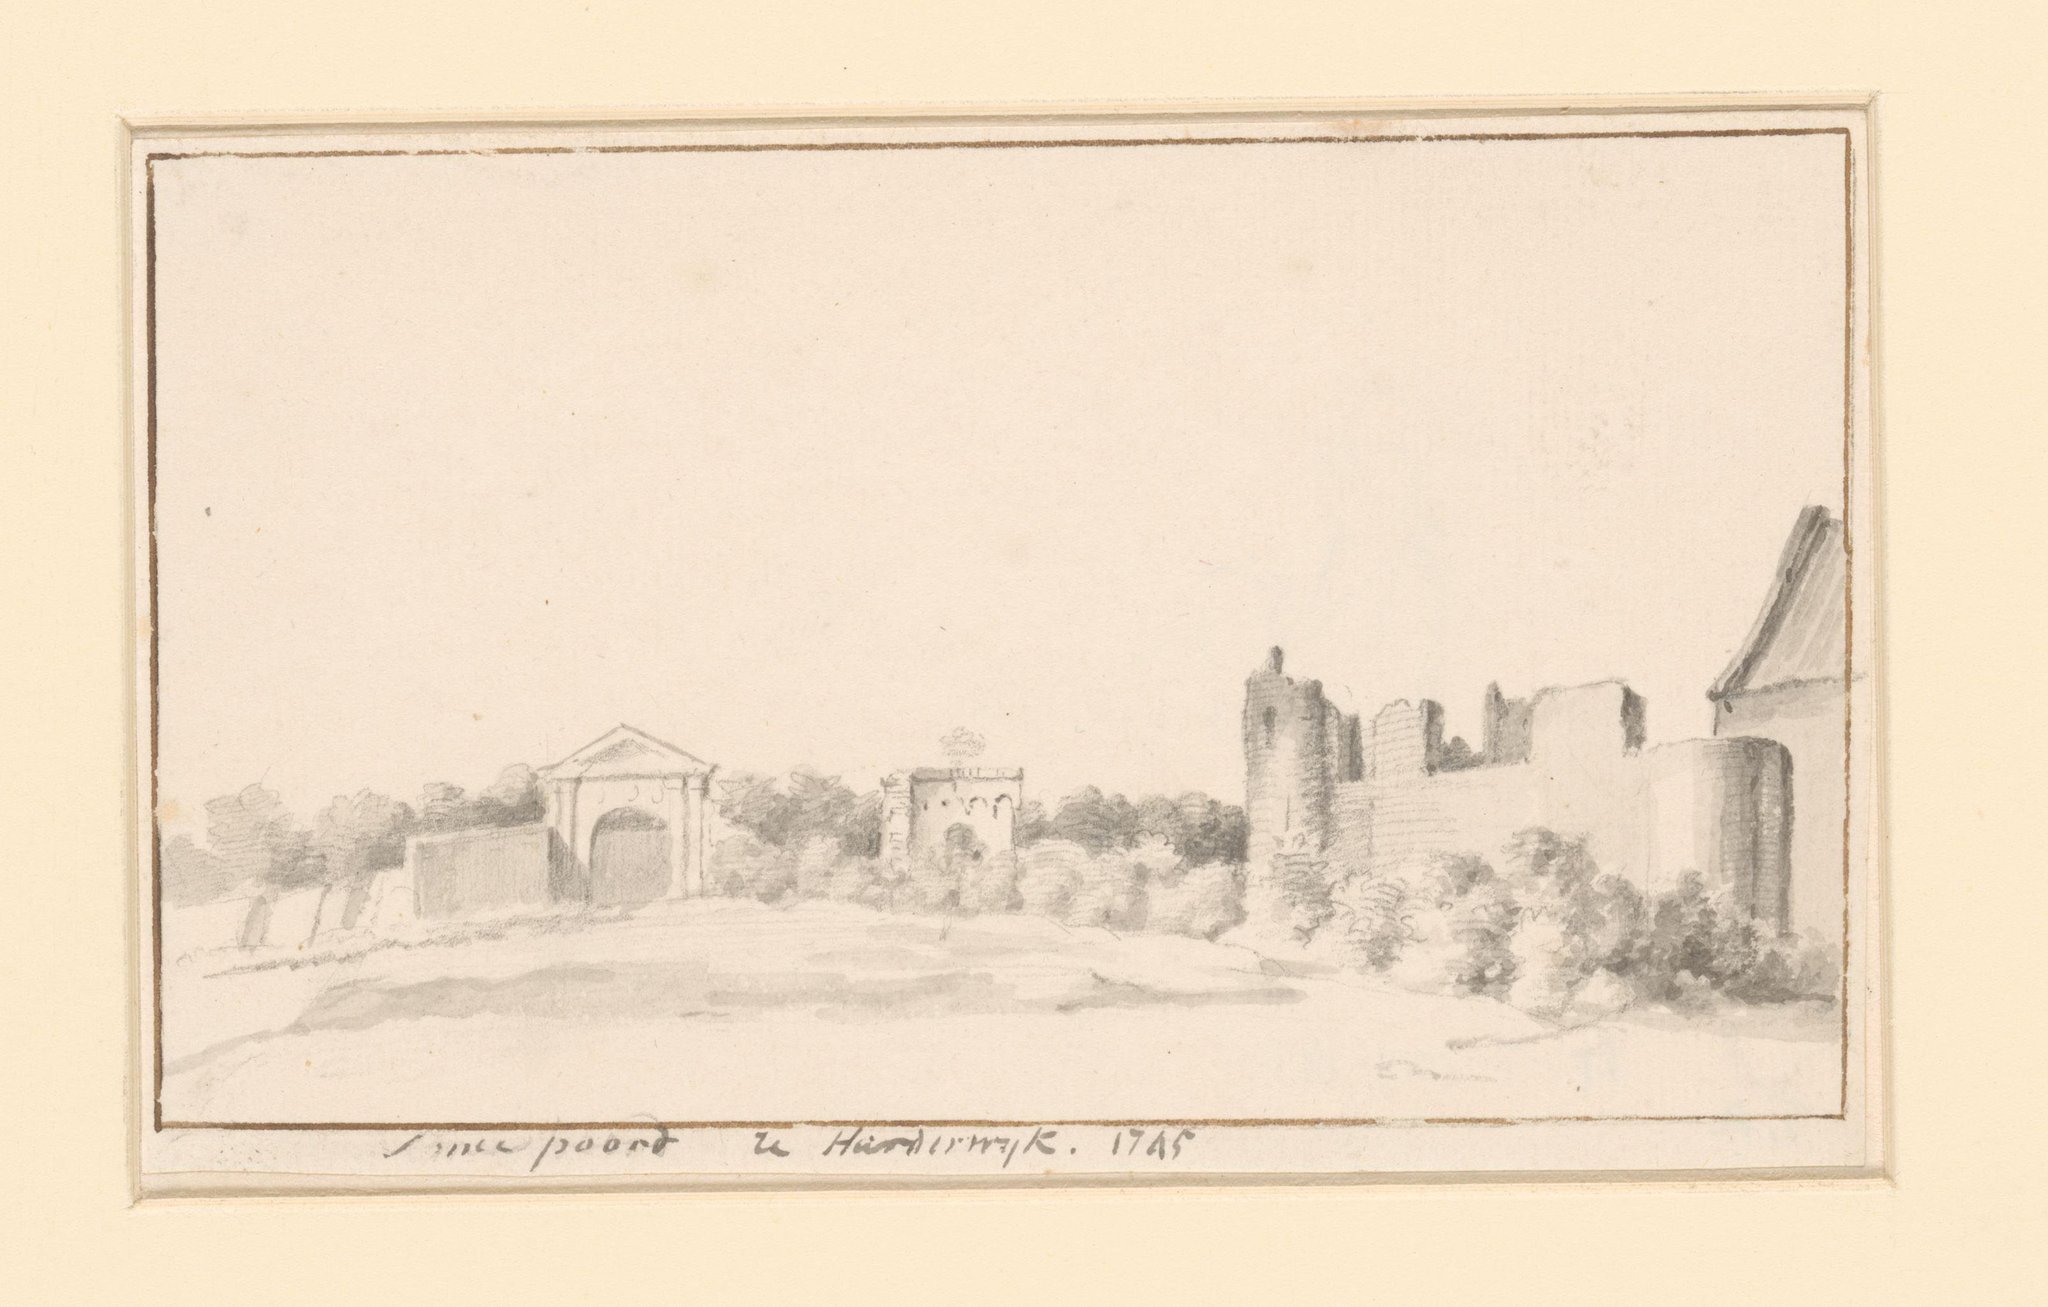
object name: drawing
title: Smee poort te Harderwijk 1745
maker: Anonymous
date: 1745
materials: ink, paper, pencil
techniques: brush, pen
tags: city-gate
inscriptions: inscription: ‘Smee poort te Harderwijk 1745’